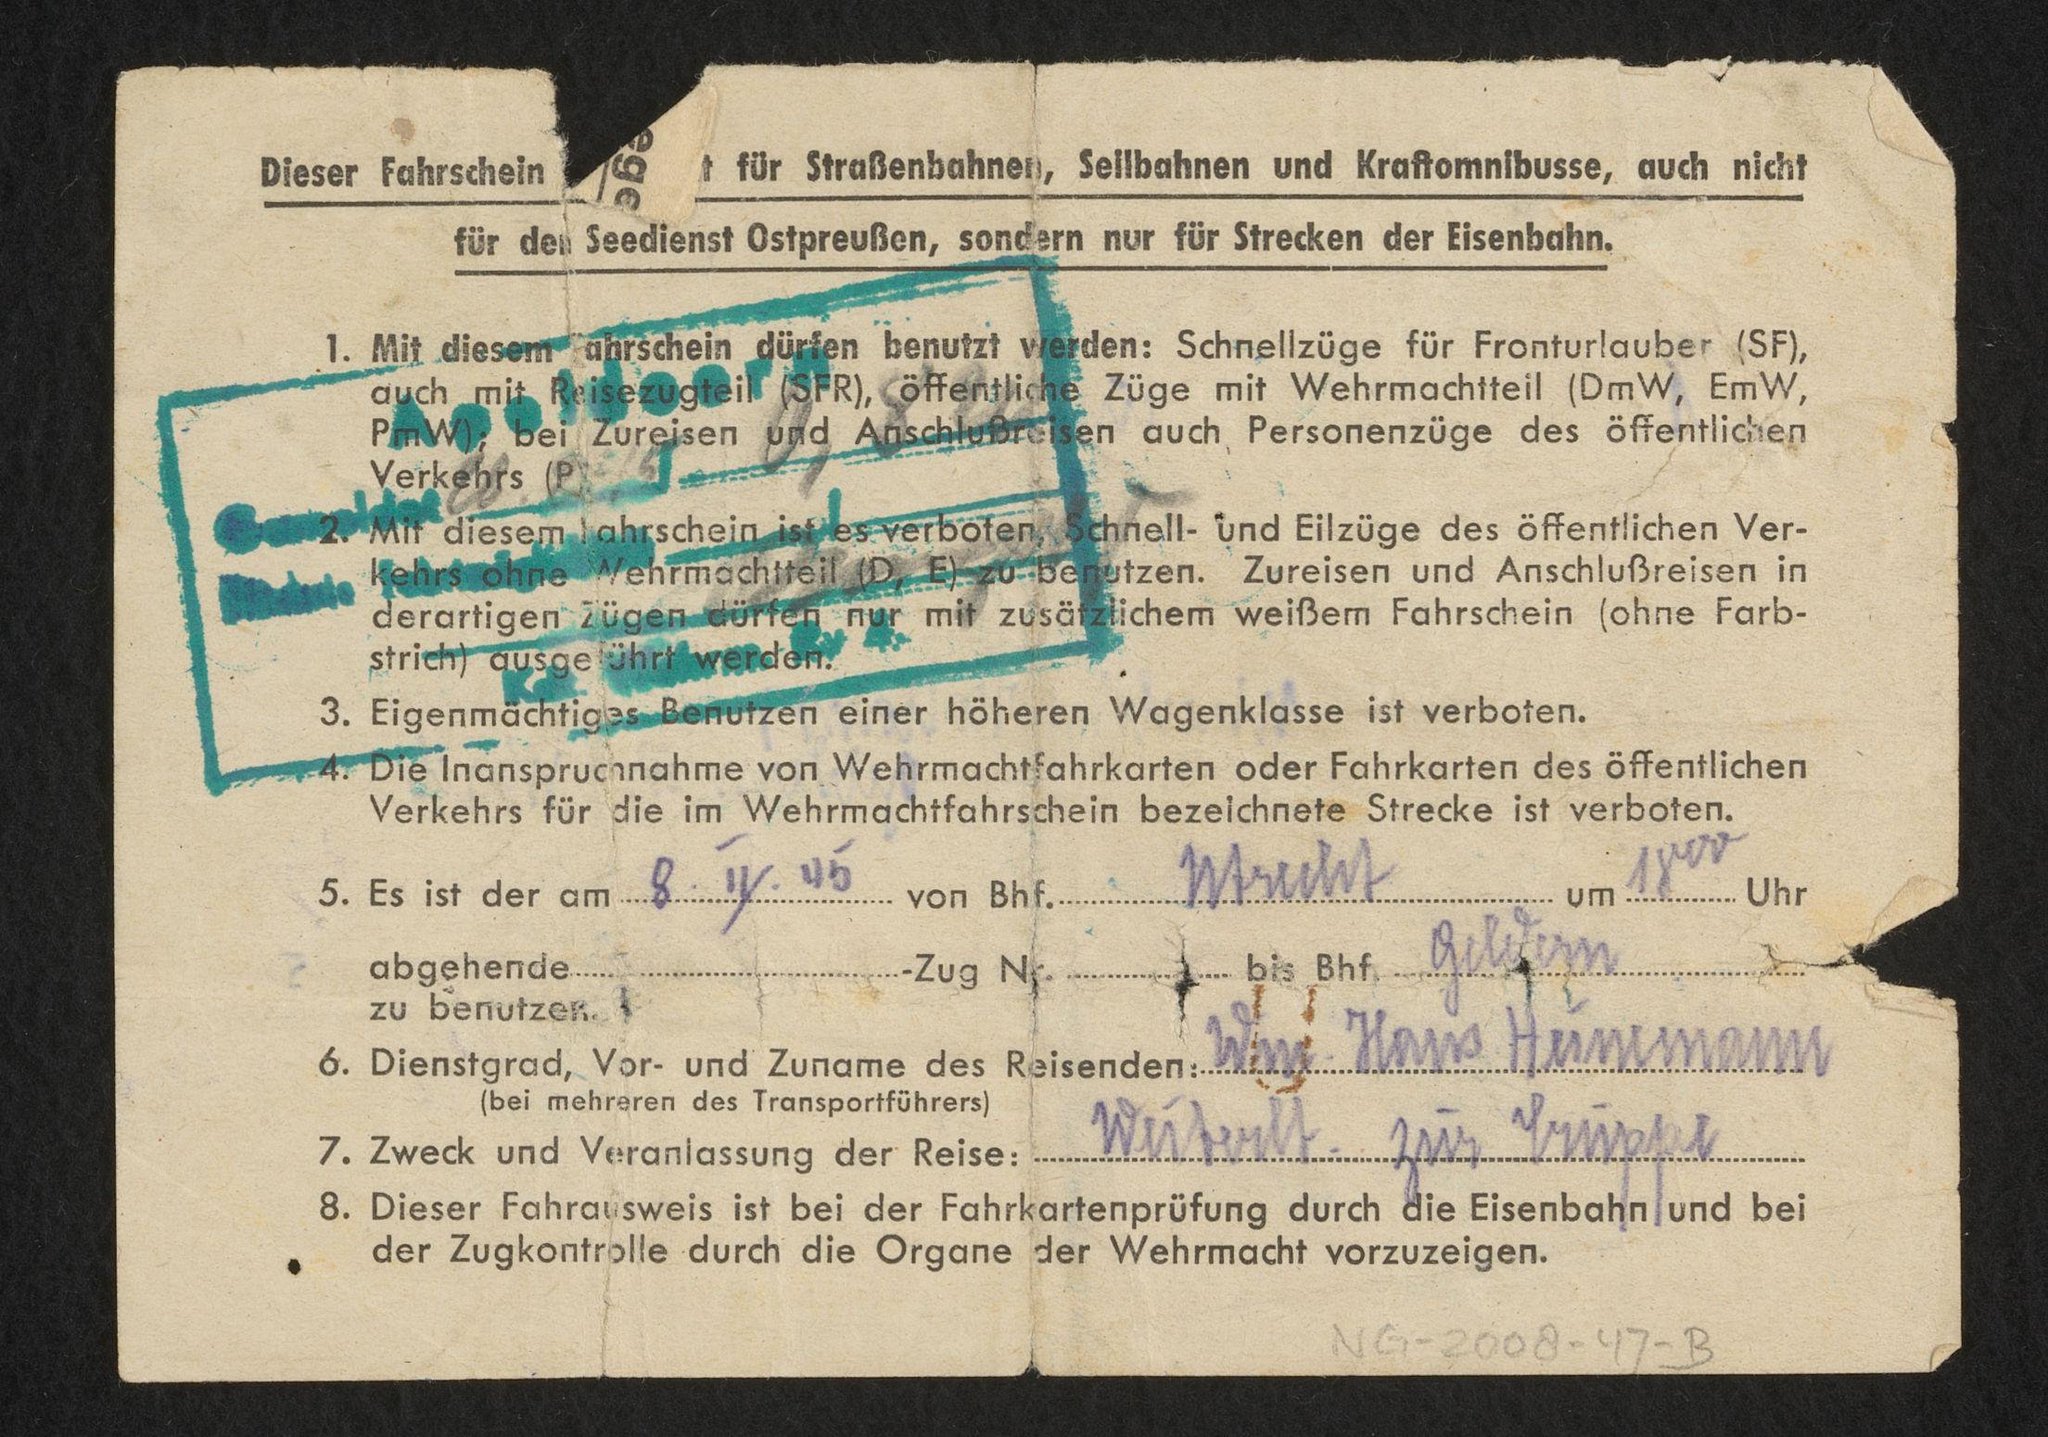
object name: document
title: Kleiner Wehrmachtfahrschein, Teil 2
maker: Anonymous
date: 1945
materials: paper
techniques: printed materials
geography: germany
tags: communication and transport, the soldier; the soldier's life, netherlands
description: Persoonlijke reisdocument van Hans Heineman, gedateerd 8 februari 1945. Document in melinexmapje los in de doos bij het fotoalbum 'Kriegszeit in Holland' over de diensttijd in Nederland van Hans Heinemann van een Flak Regiment van de Luftverteidigungskommando van de Luftwaffe.